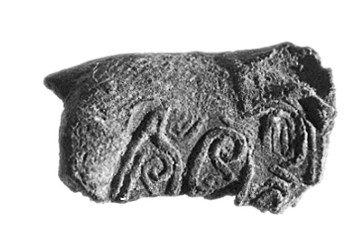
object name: sealing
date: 1981-1640 BCE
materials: mud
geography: egypt